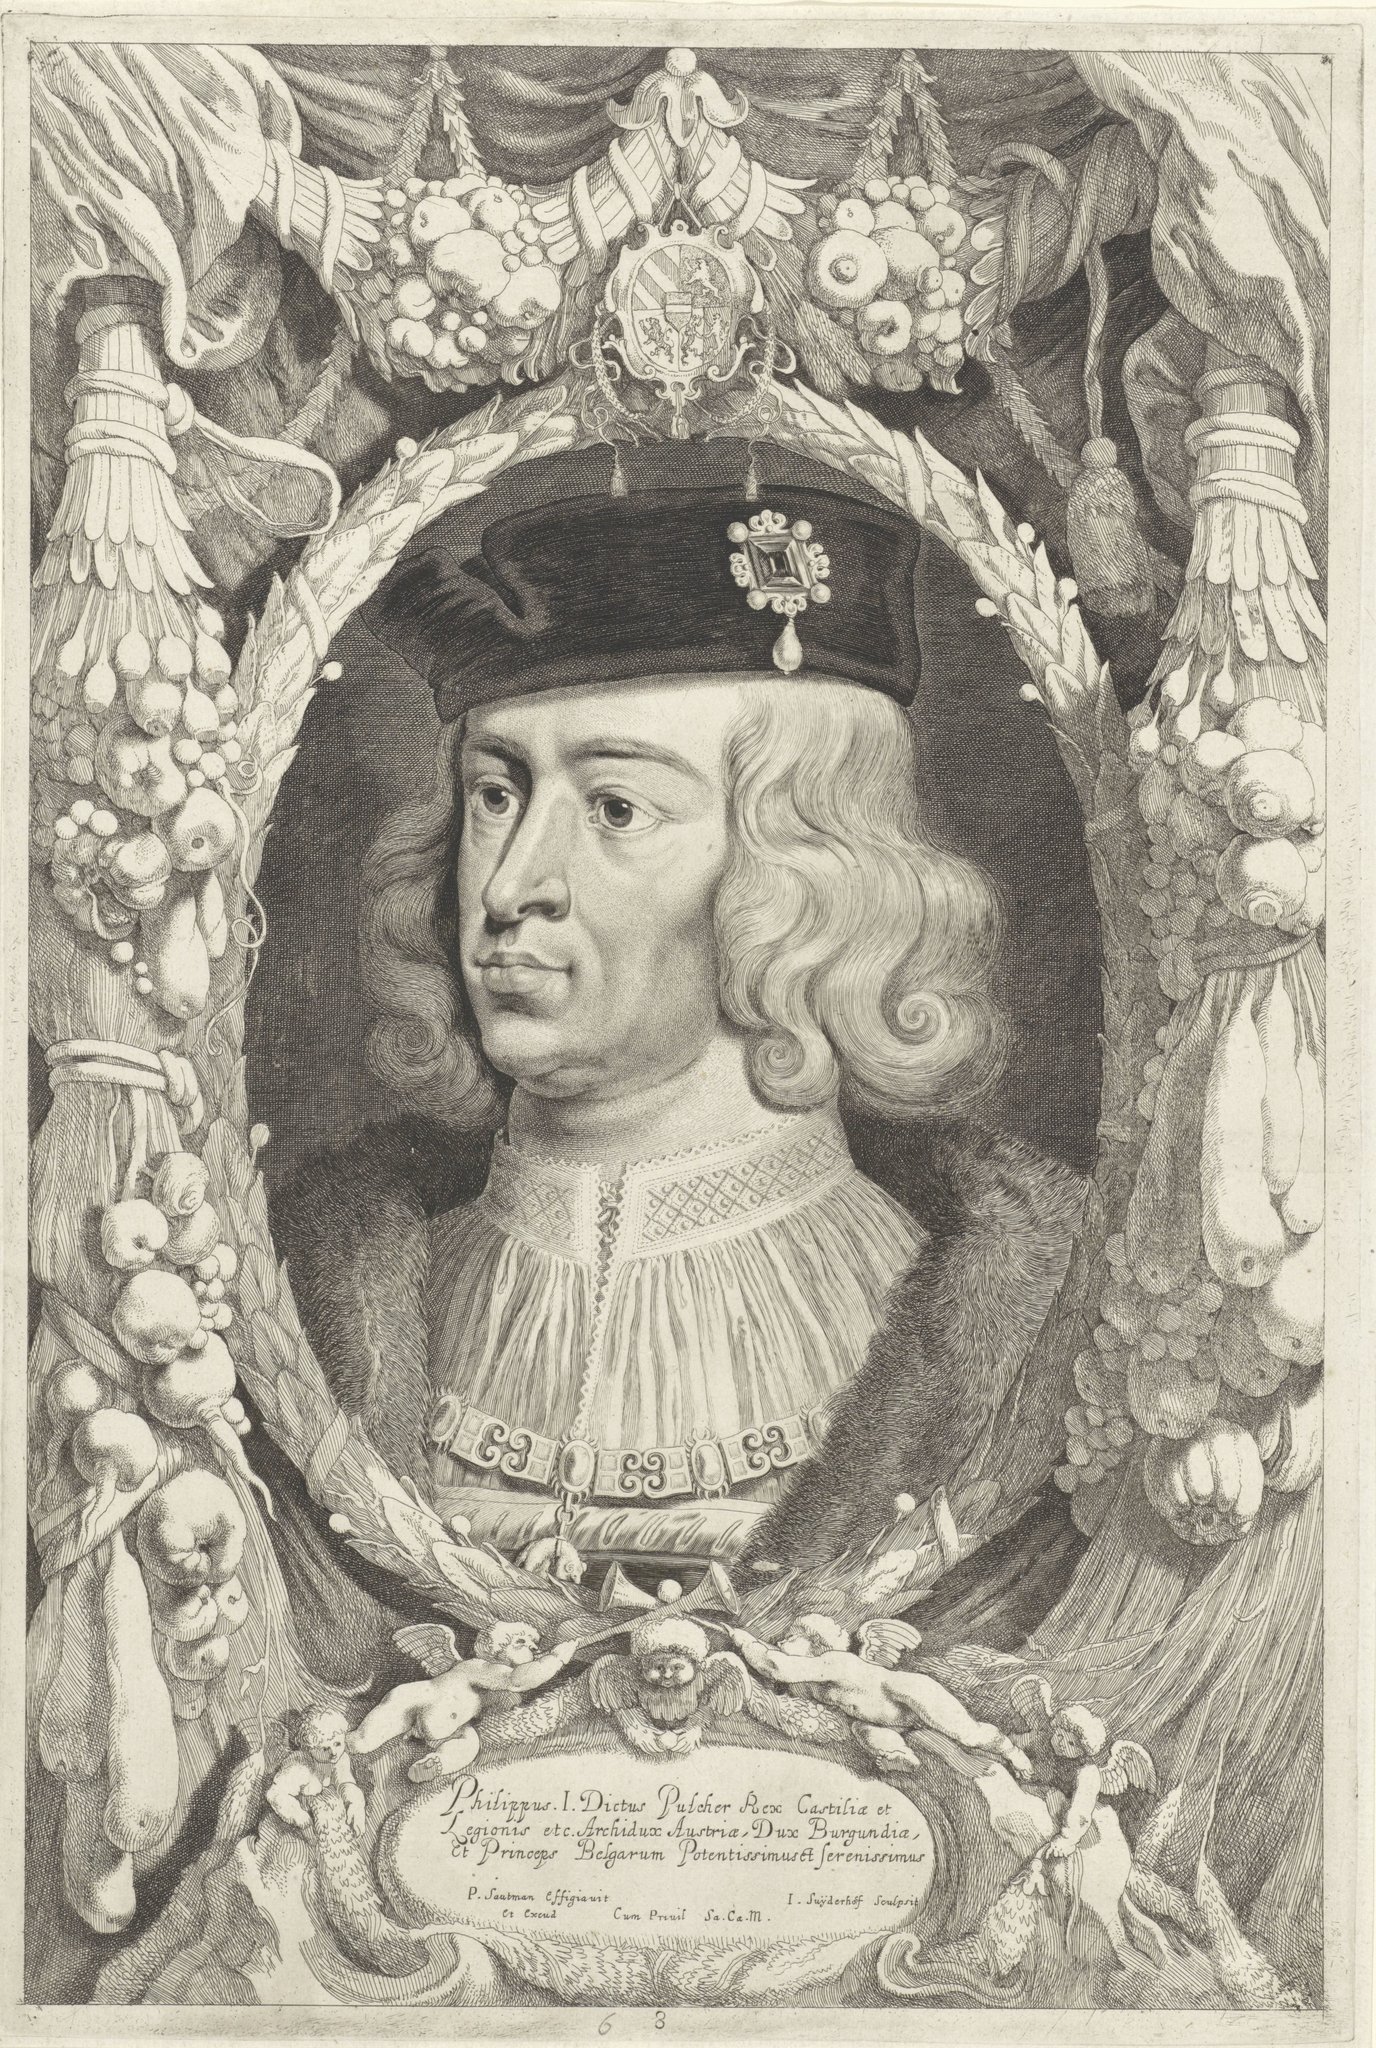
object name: print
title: Portret van Filips de Schone, hertog van Bourgondië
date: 1644-1650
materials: paper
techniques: engraving, etching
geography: haarlem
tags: filips de schone (hertog van bourgondië), knighthood order of the golden fleece - insignia of a knighthood order, e.g.: badge, chain (with name of order), ornament ~ festoon, garland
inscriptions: collector's mark: Lugt 2228, collector's mark: Lugt 2760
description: Portret van Filips de Schone, hertog van Bourgondië, met een keten met het ordeteken van de Orde van het Gulden Vlies om zijn hals. Het portret is gevat in een ornamentele omlijsting van guirlandes met vruchten. Midden boven zijn wapenschild. Midden onder een cartouche met zijn naam en titel in het Latijn.